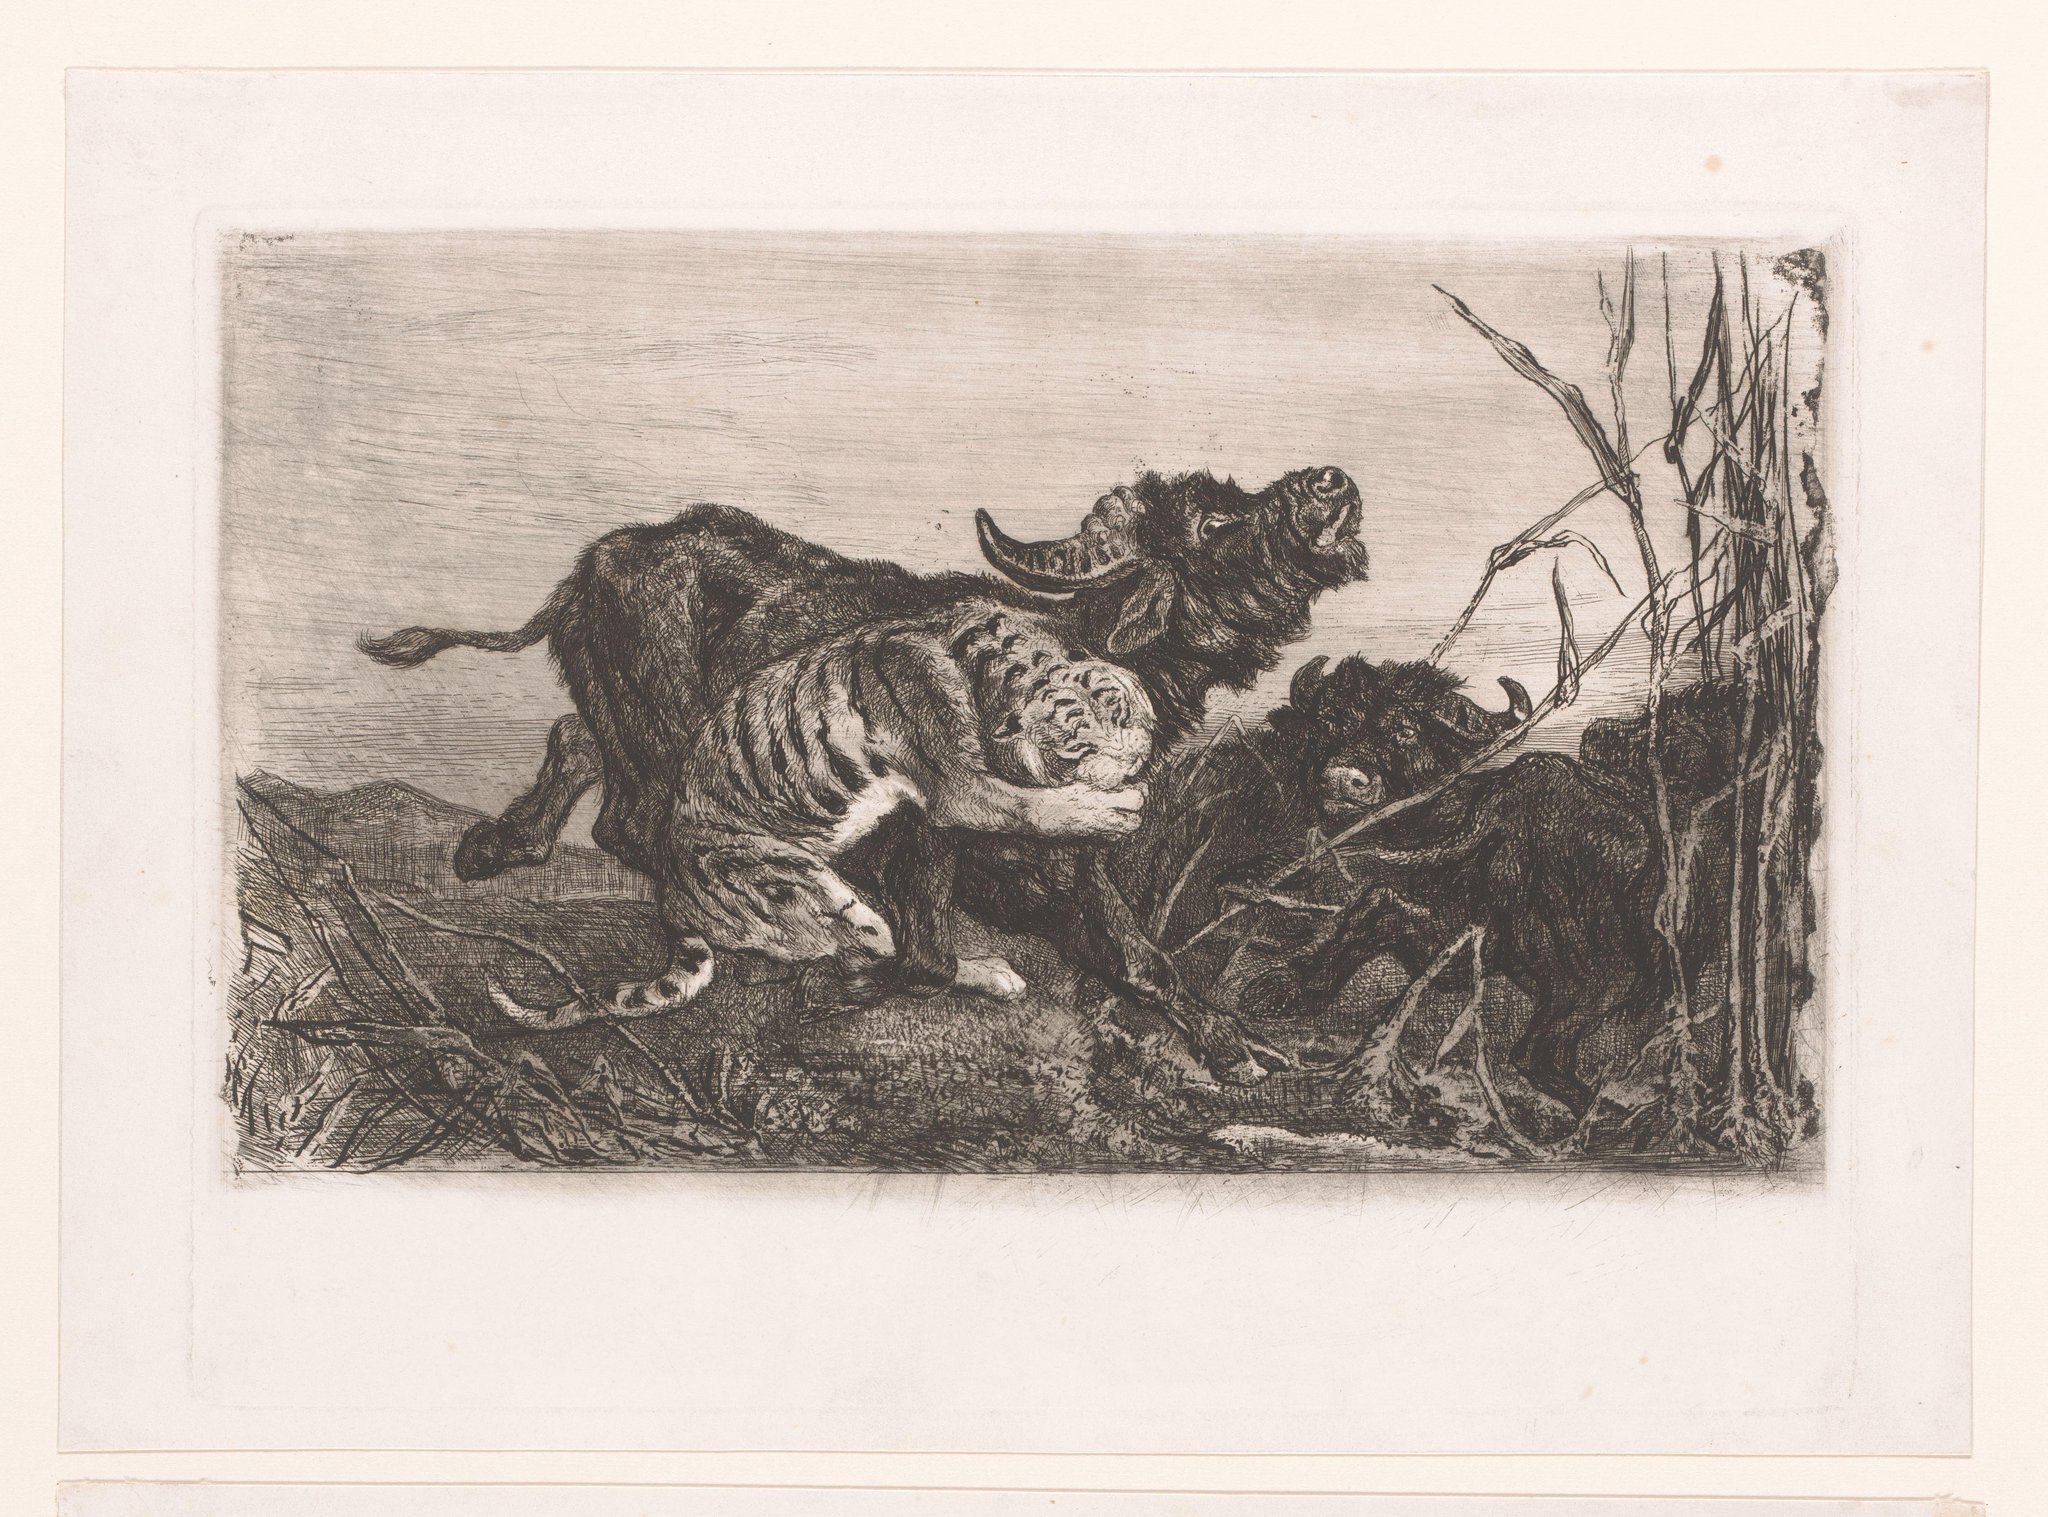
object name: print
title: Buffels door een tijger aangevallen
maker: charles verlat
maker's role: painter, print maker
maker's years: 1824-1890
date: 1868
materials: paper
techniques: drypoint, etching, intaglio, retroussage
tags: hoofed animals: buffalo, beasts of prey, predatory animals: tiger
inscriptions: collector's mark: Lugt 1485, collector's mark: Lugt 2228